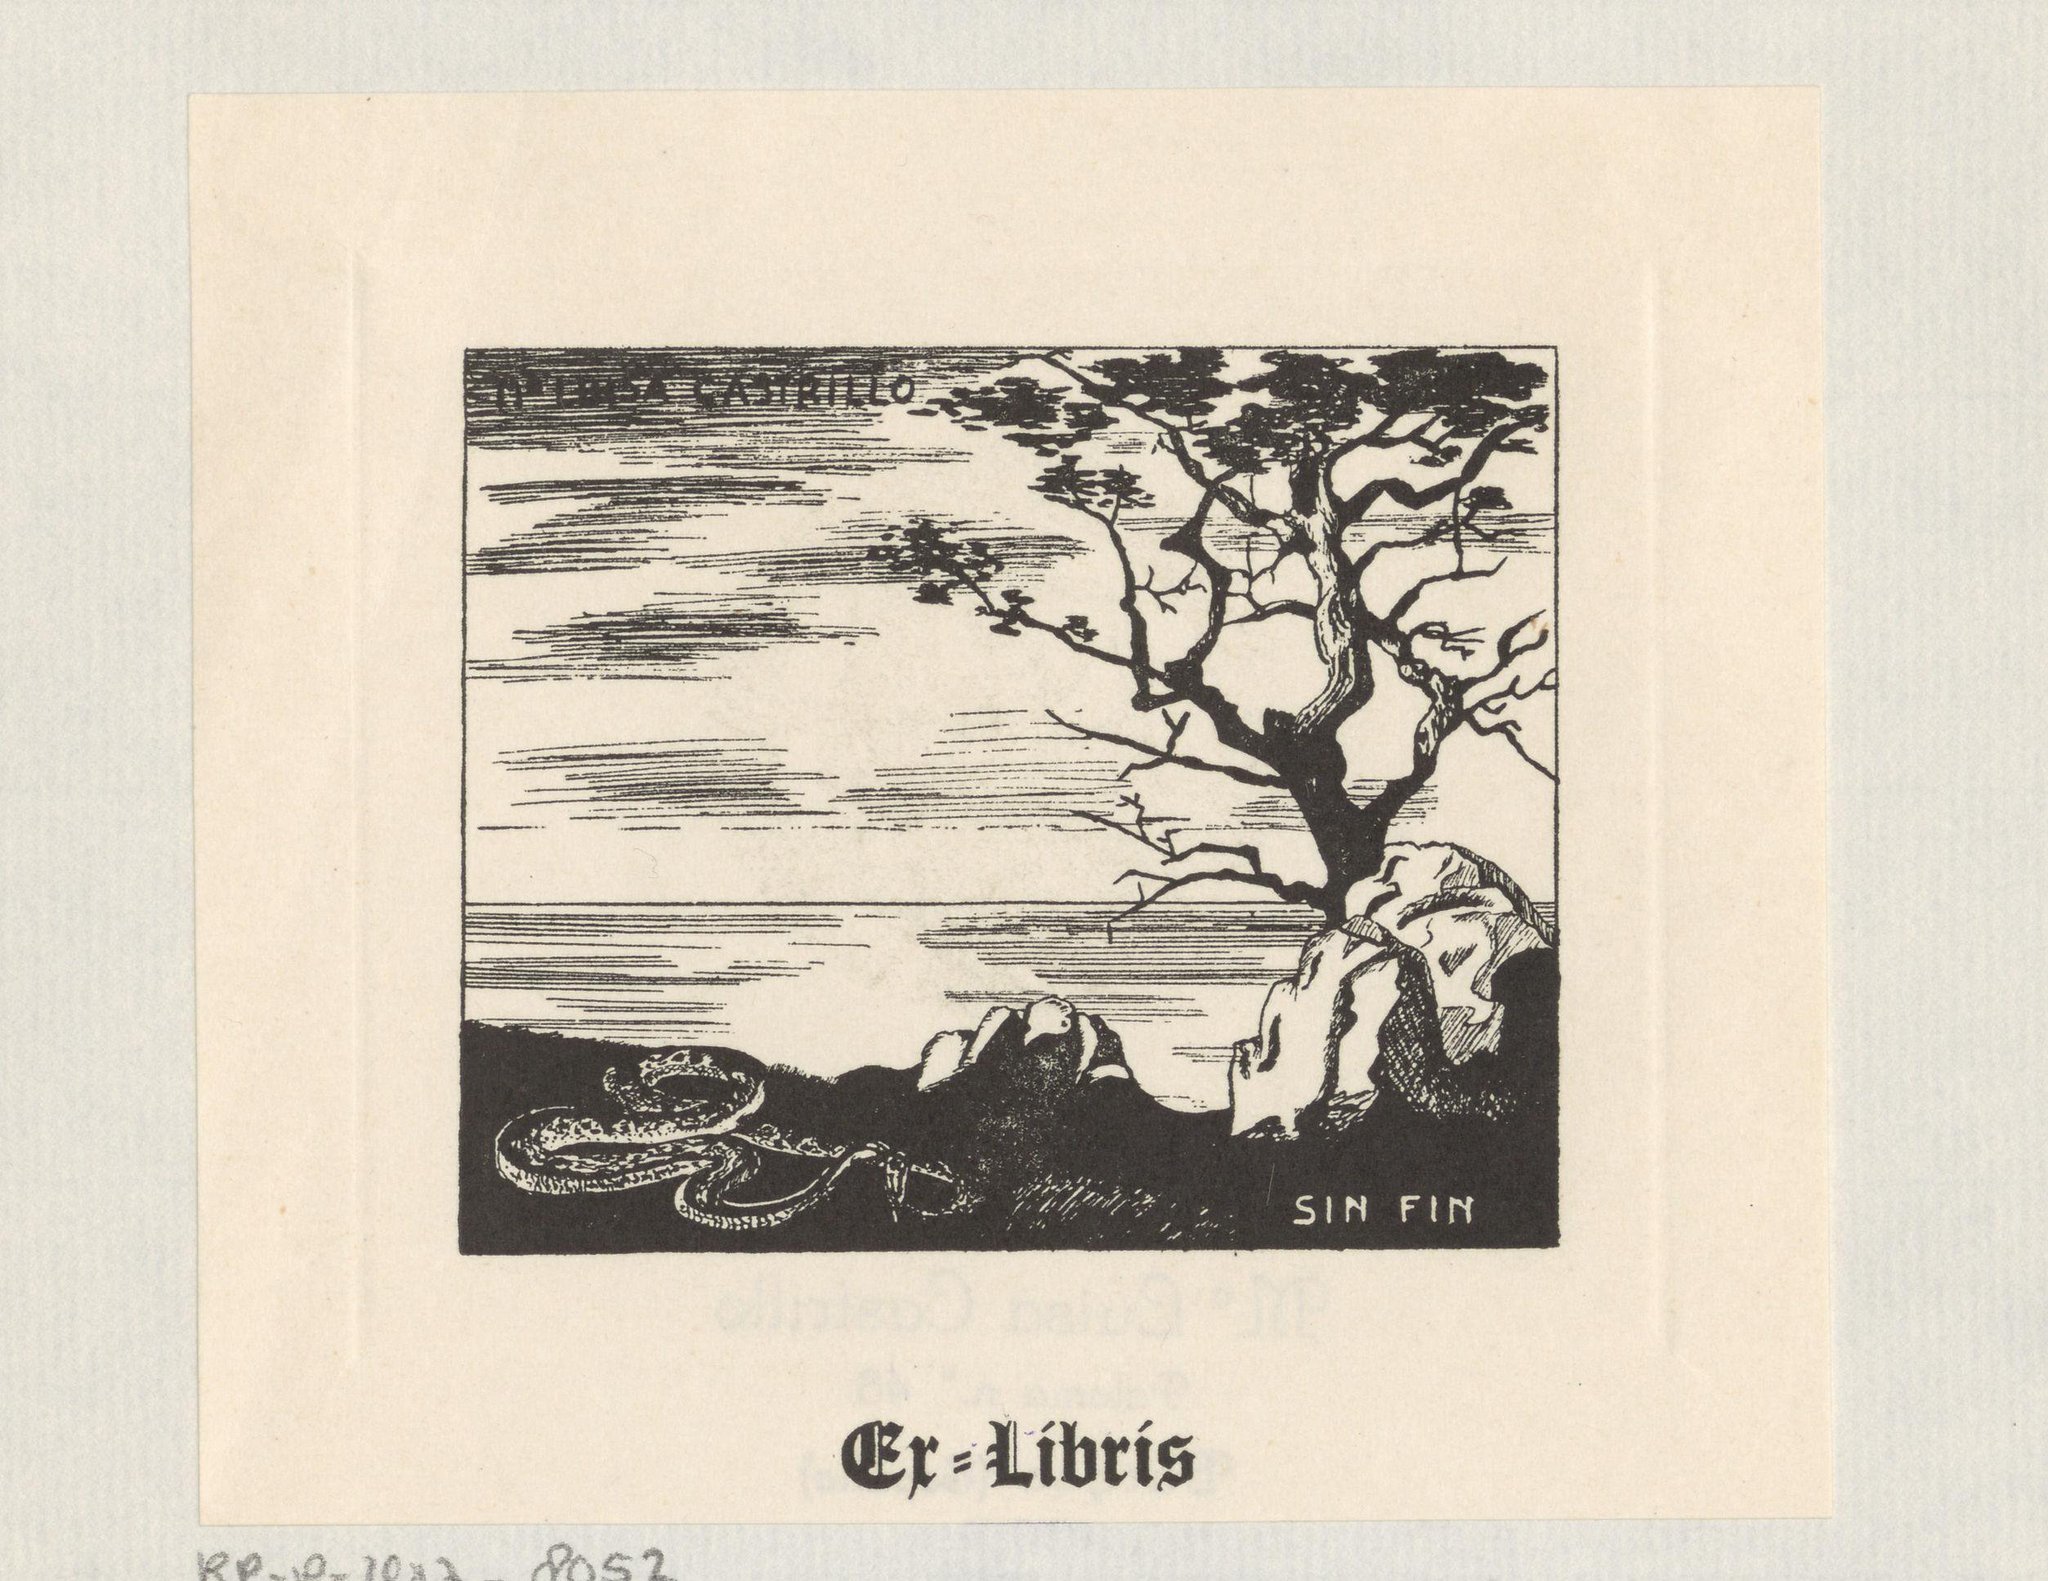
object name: bookplate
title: Ex libris van Luisa Castrillo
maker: Anonymous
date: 1900-1999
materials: paper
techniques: printing block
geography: spain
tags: snakes, trees, landscapes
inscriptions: stamp: ‘Ma. Luisa Castrillo/ Paloma no. 48/ Burgos (España)’